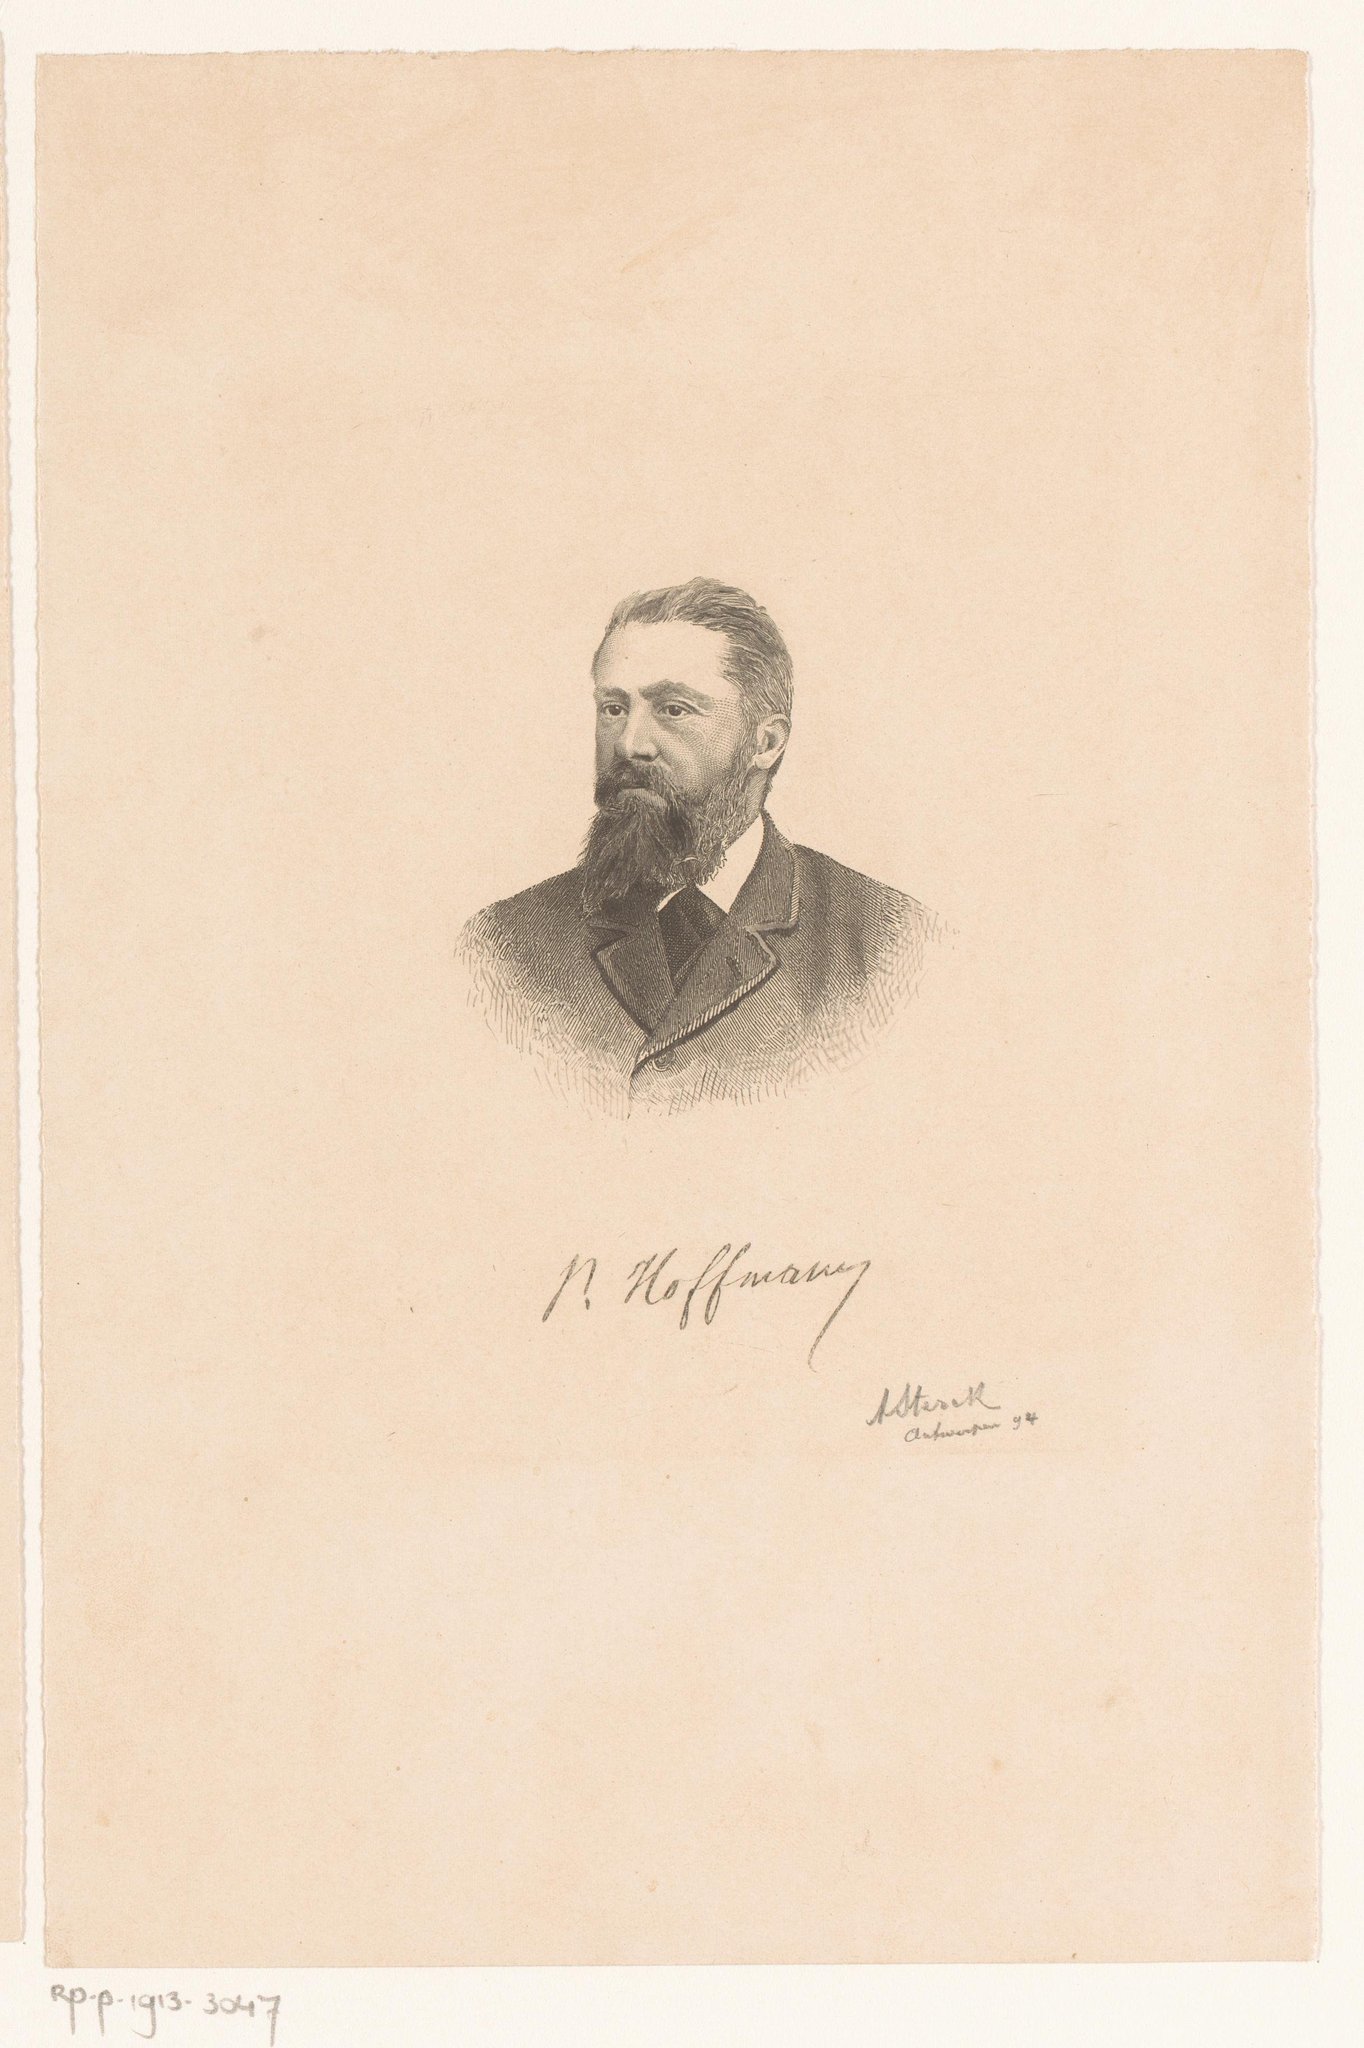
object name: print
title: Portret van een onbekende man, mogelijk P. Hoffmann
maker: arthur sterck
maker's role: print maker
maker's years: 1868-1897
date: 1894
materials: paper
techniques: etching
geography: antwerp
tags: historical persons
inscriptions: collector's mark: Lugt 2228